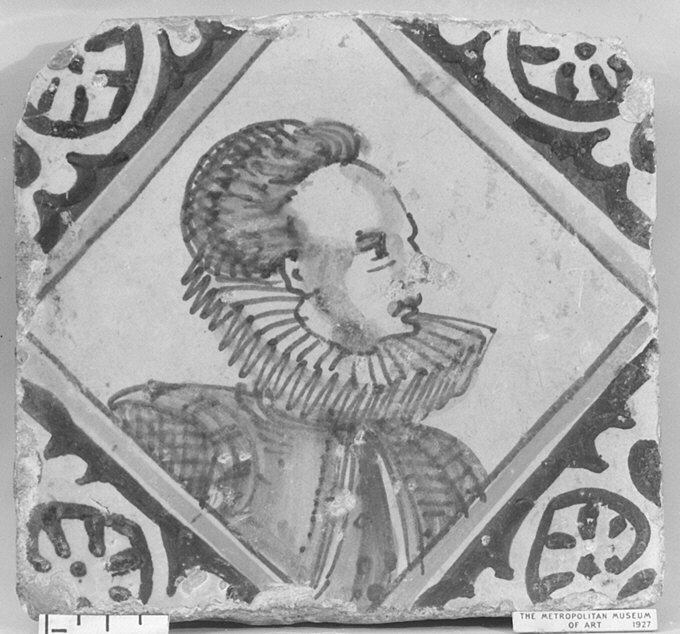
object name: tile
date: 1600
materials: earthenware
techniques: glazing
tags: men,profiles